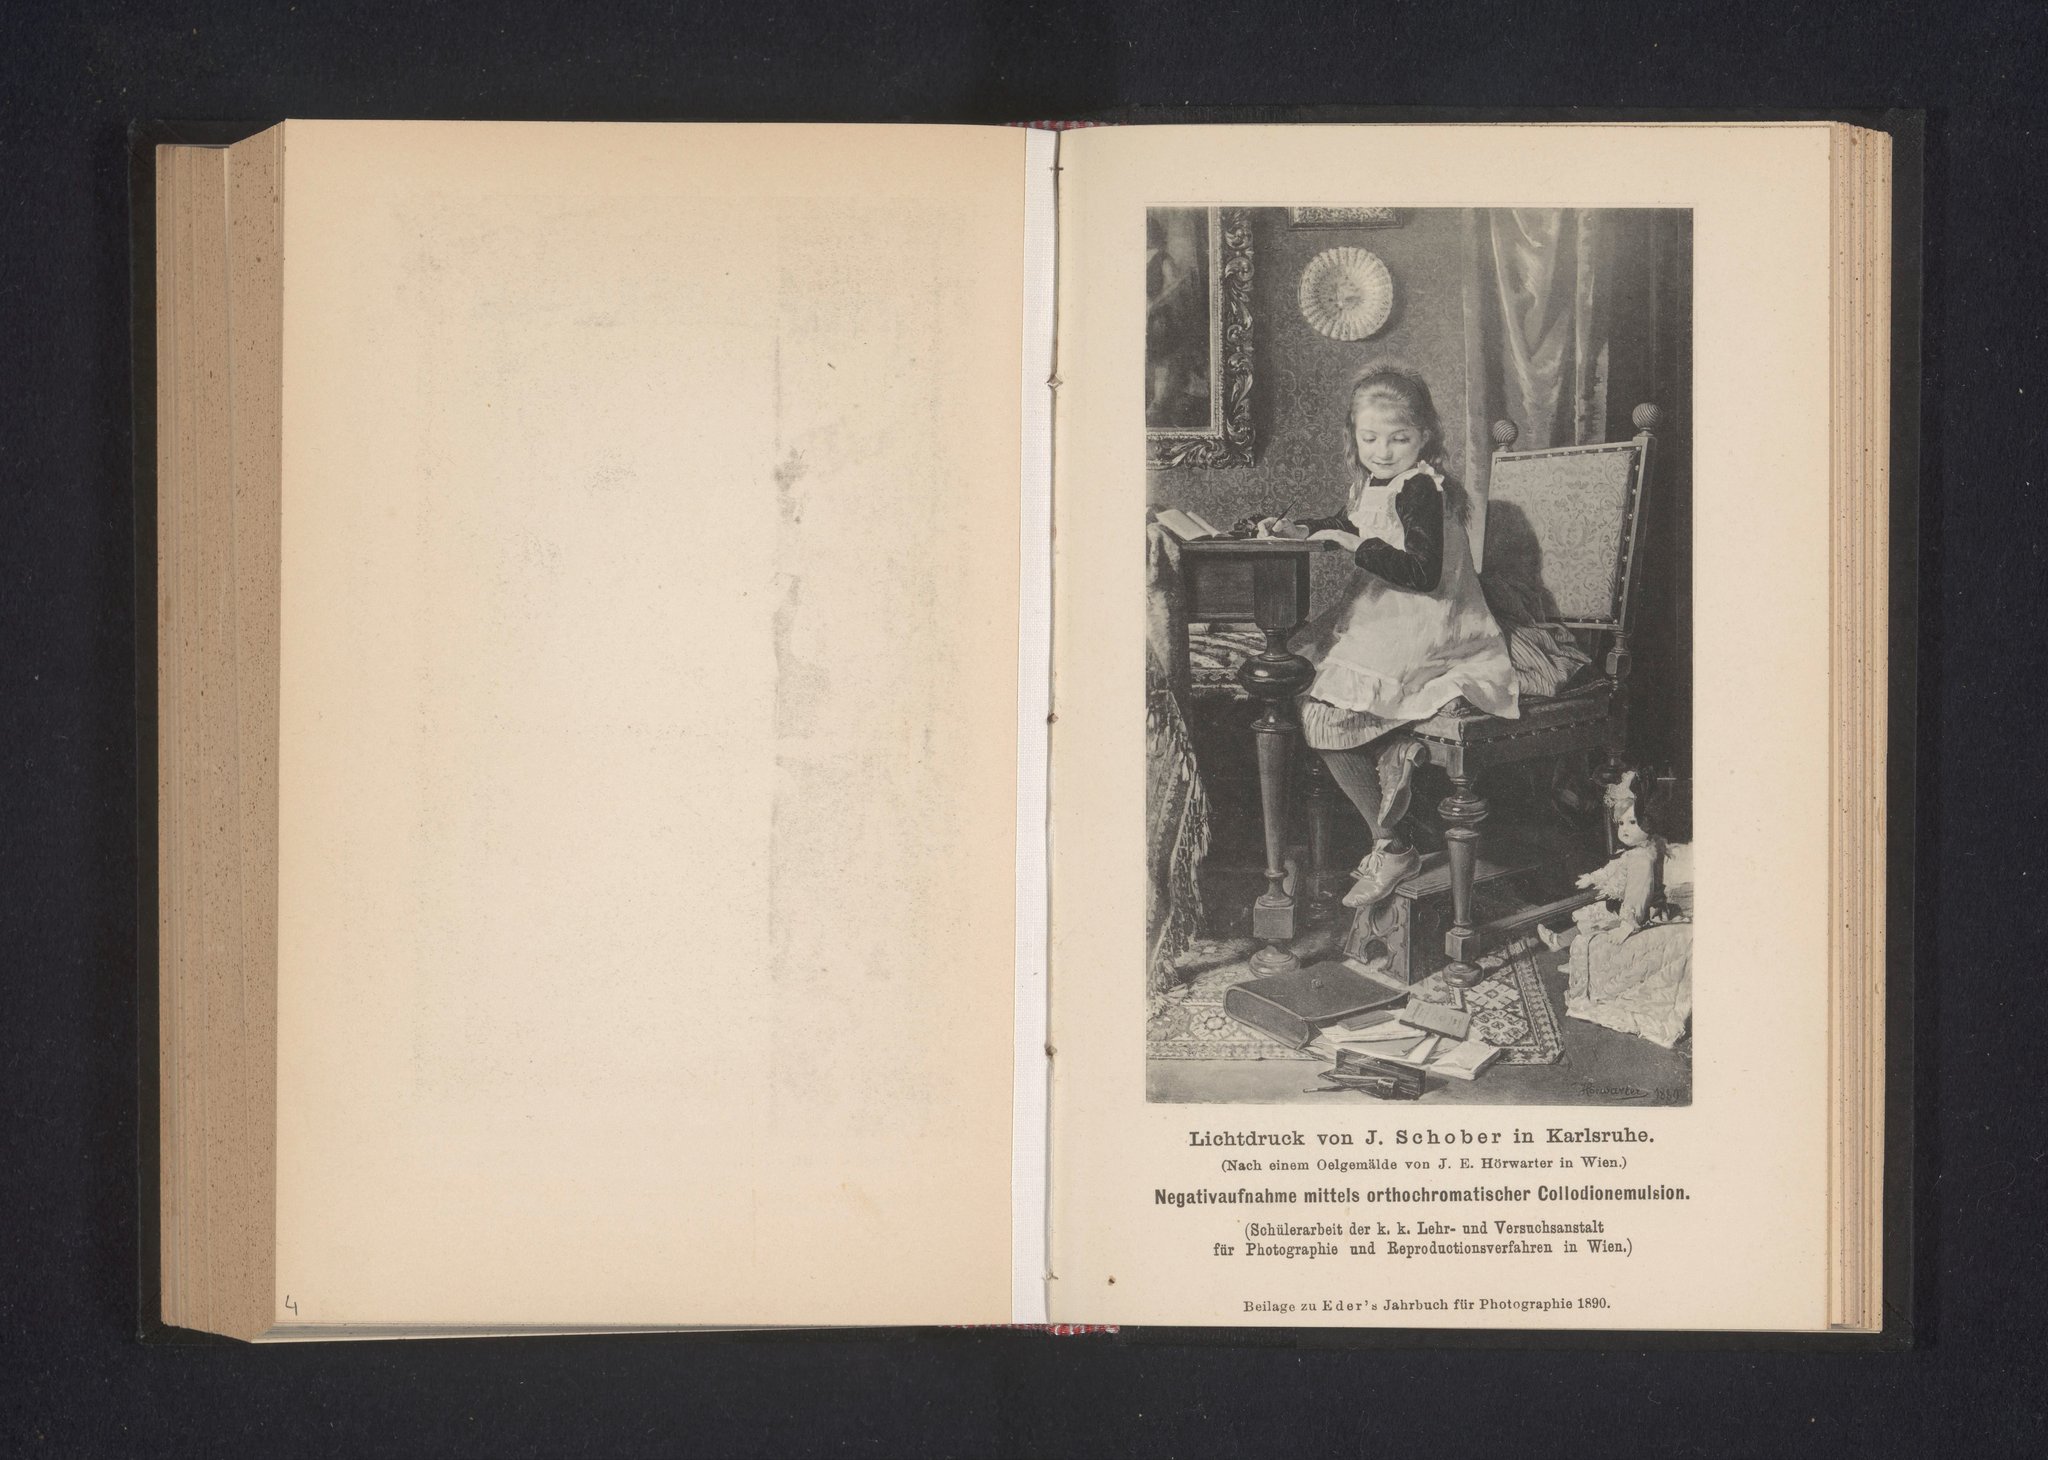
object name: photomechanical print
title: Reproductie van een schilderij van een schrijvend meisje door Joseph Eugen Hörwarter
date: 1885-1890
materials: paper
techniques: photograph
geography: karlsruhe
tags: historical persons - bb - woman, girl (child between toddler and youth)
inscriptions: inscription: ‘Negativaufnahme mittels orthochromatischer Collodionemulsion/ Beilage zu Eder's Jahrbuch für Photographie 1890.’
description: Prent op elfde ongenummerde pagina na pagina 400.